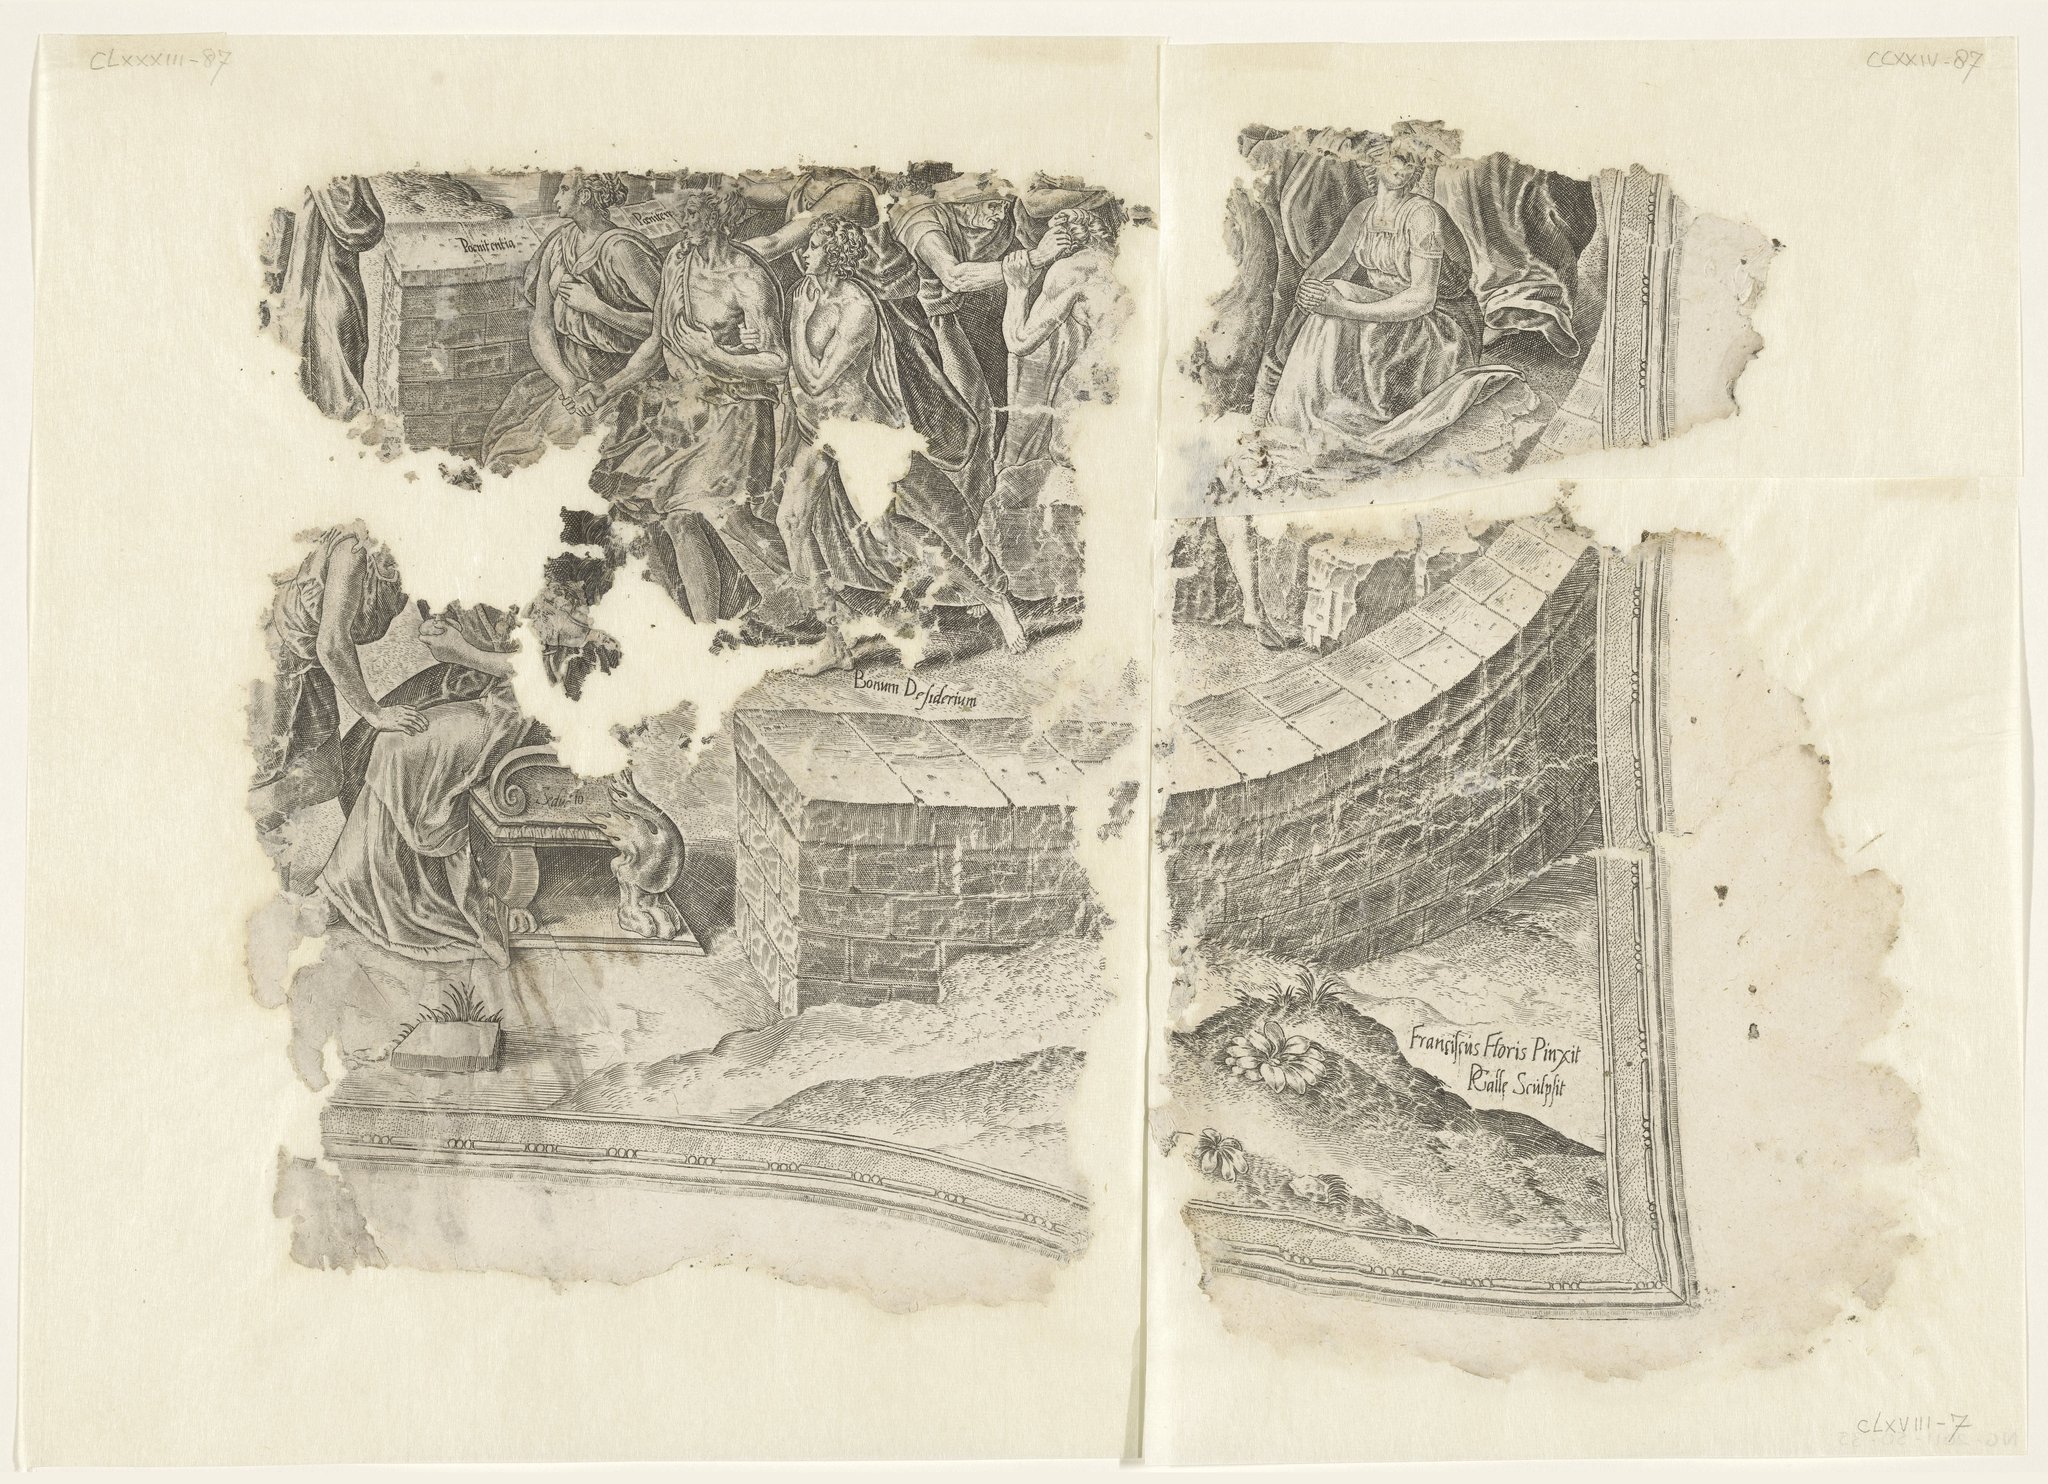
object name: print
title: Rechteronderhoek van een prent van het tafereel van Cebes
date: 1561-1596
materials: paper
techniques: engraving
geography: southern netherlands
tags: 'tabula cebetis'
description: Allegorie over de heilsweg van de mens. Het leven als een stad met drie ommuurde terreinen, met in het midden een tempel. Bij de buitenste poort staan de zielen van kinderen te wachten, klaar om het volwassen leven te betreden. Voor het binnengaan krijgen zij iets te drinken van Verleiding (Seductio), die hen onwetend maakt. Het eerste ommuurde terrein toont allerlei ver- en afleidingen, zoals Vooroordeel (Opinio), Begeerte (Cupiduas), Twijfel (Error) en Onwetendheid (Ignorantia). Zij beletten de jeugdige mens verder door te dringen tot de volgende cirkel. Alleen door de personificaties te volgen van Berouw (Poenitentia), Hoop (Spes) en Goed Verlangen (Bonnem Desiderium) kan de mens toegang krijgen tot de tweede cirkel. Daar krijgt hij onderricht in alle vormen van wereldse kennis. Links staan de zeven artes liberales en rechts debatteren verschillende geleerden. De mens wordt in deze cirkel op de proef gesteld en geconfronteerd met valse kennis (Falsa Disciplina). Met behulp van Zelfbeheersing (Continentia) en Geduldigheid (Tolerantia) kan de berg verder worden beklommen. Het derde ommuurde terrein, ten slotte, wordt bewaakt door Waarheid (Veritas). Zij verleent de mens toegang tot het ware geluk. Hij wordt er verwelkomd door de kardinale deugden en mag verblijven in het huis van de gelukzaligen, waar het ware geluk op hem wacht. Gereconstrueerd uit drie fragmenten.